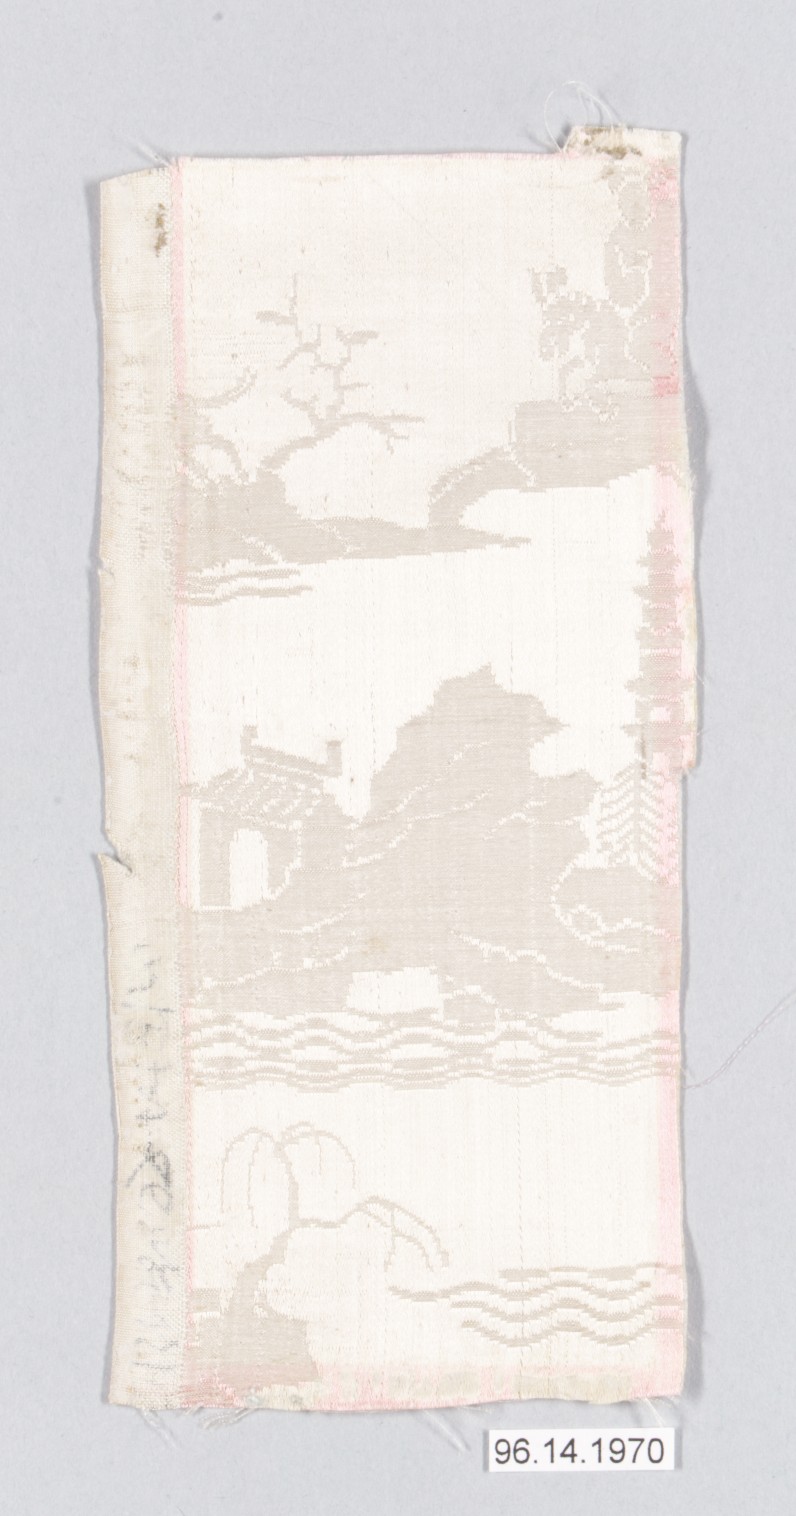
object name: piece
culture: japanese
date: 1801-1900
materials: silk